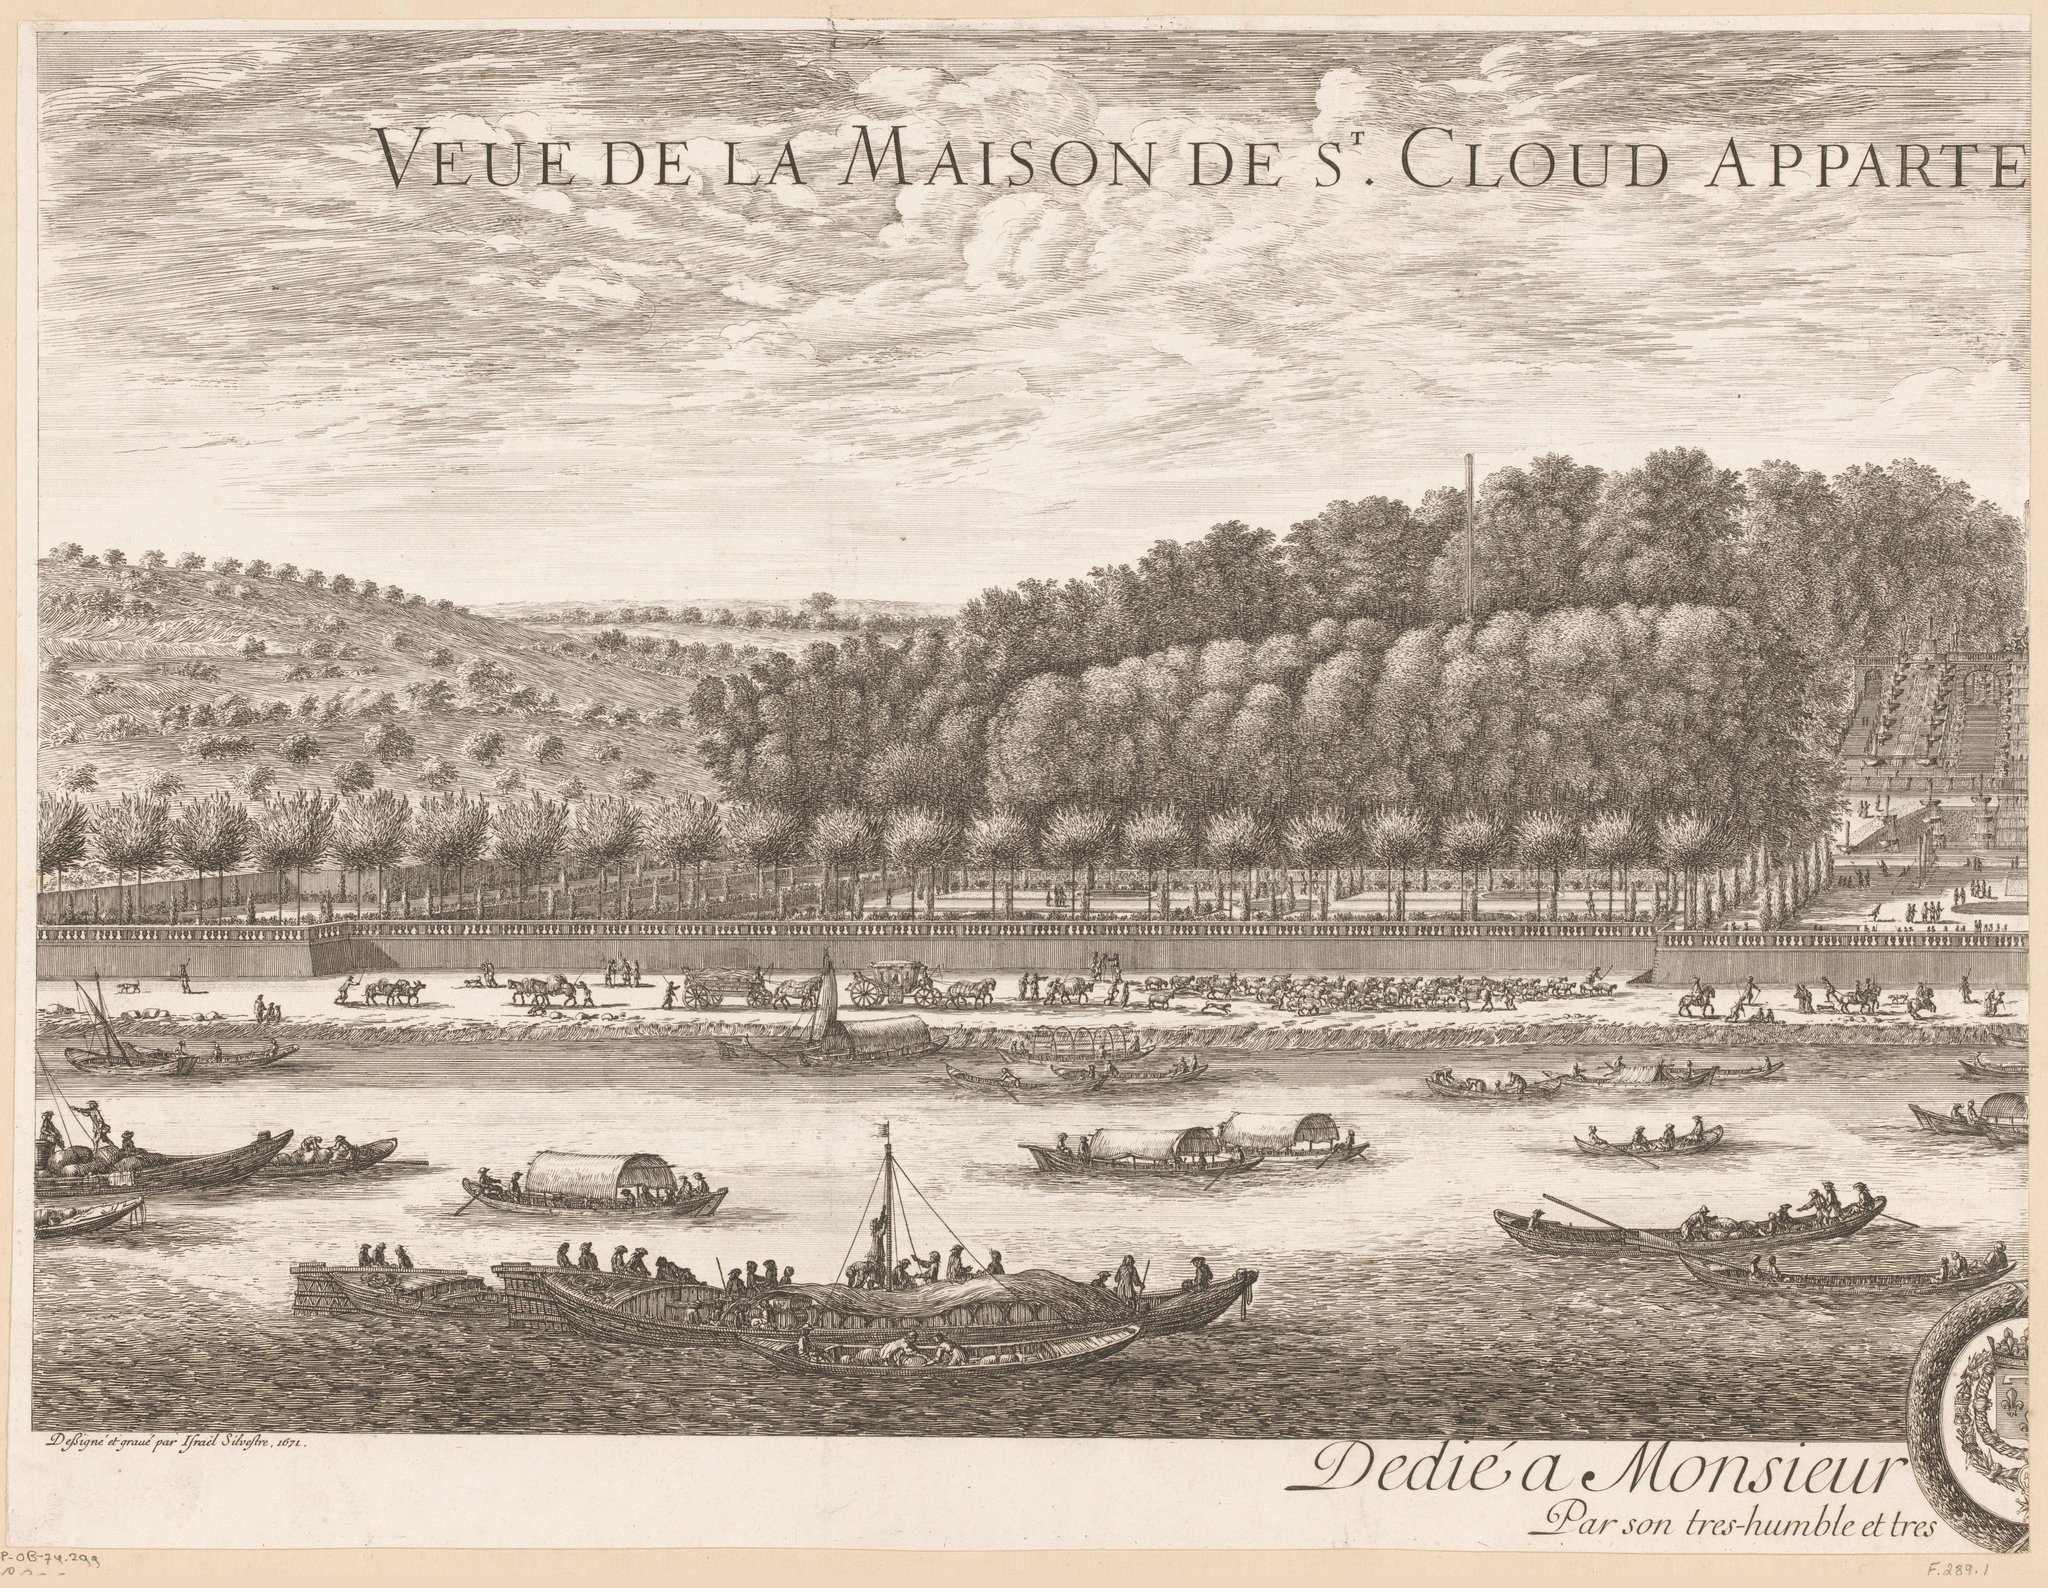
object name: print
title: Veue de la maison de St. Cloud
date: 1671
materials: paper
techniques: engraving, etching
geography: paris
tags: city-view, and landscape with man-made constructions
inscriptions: collector's mark: Lugt 240